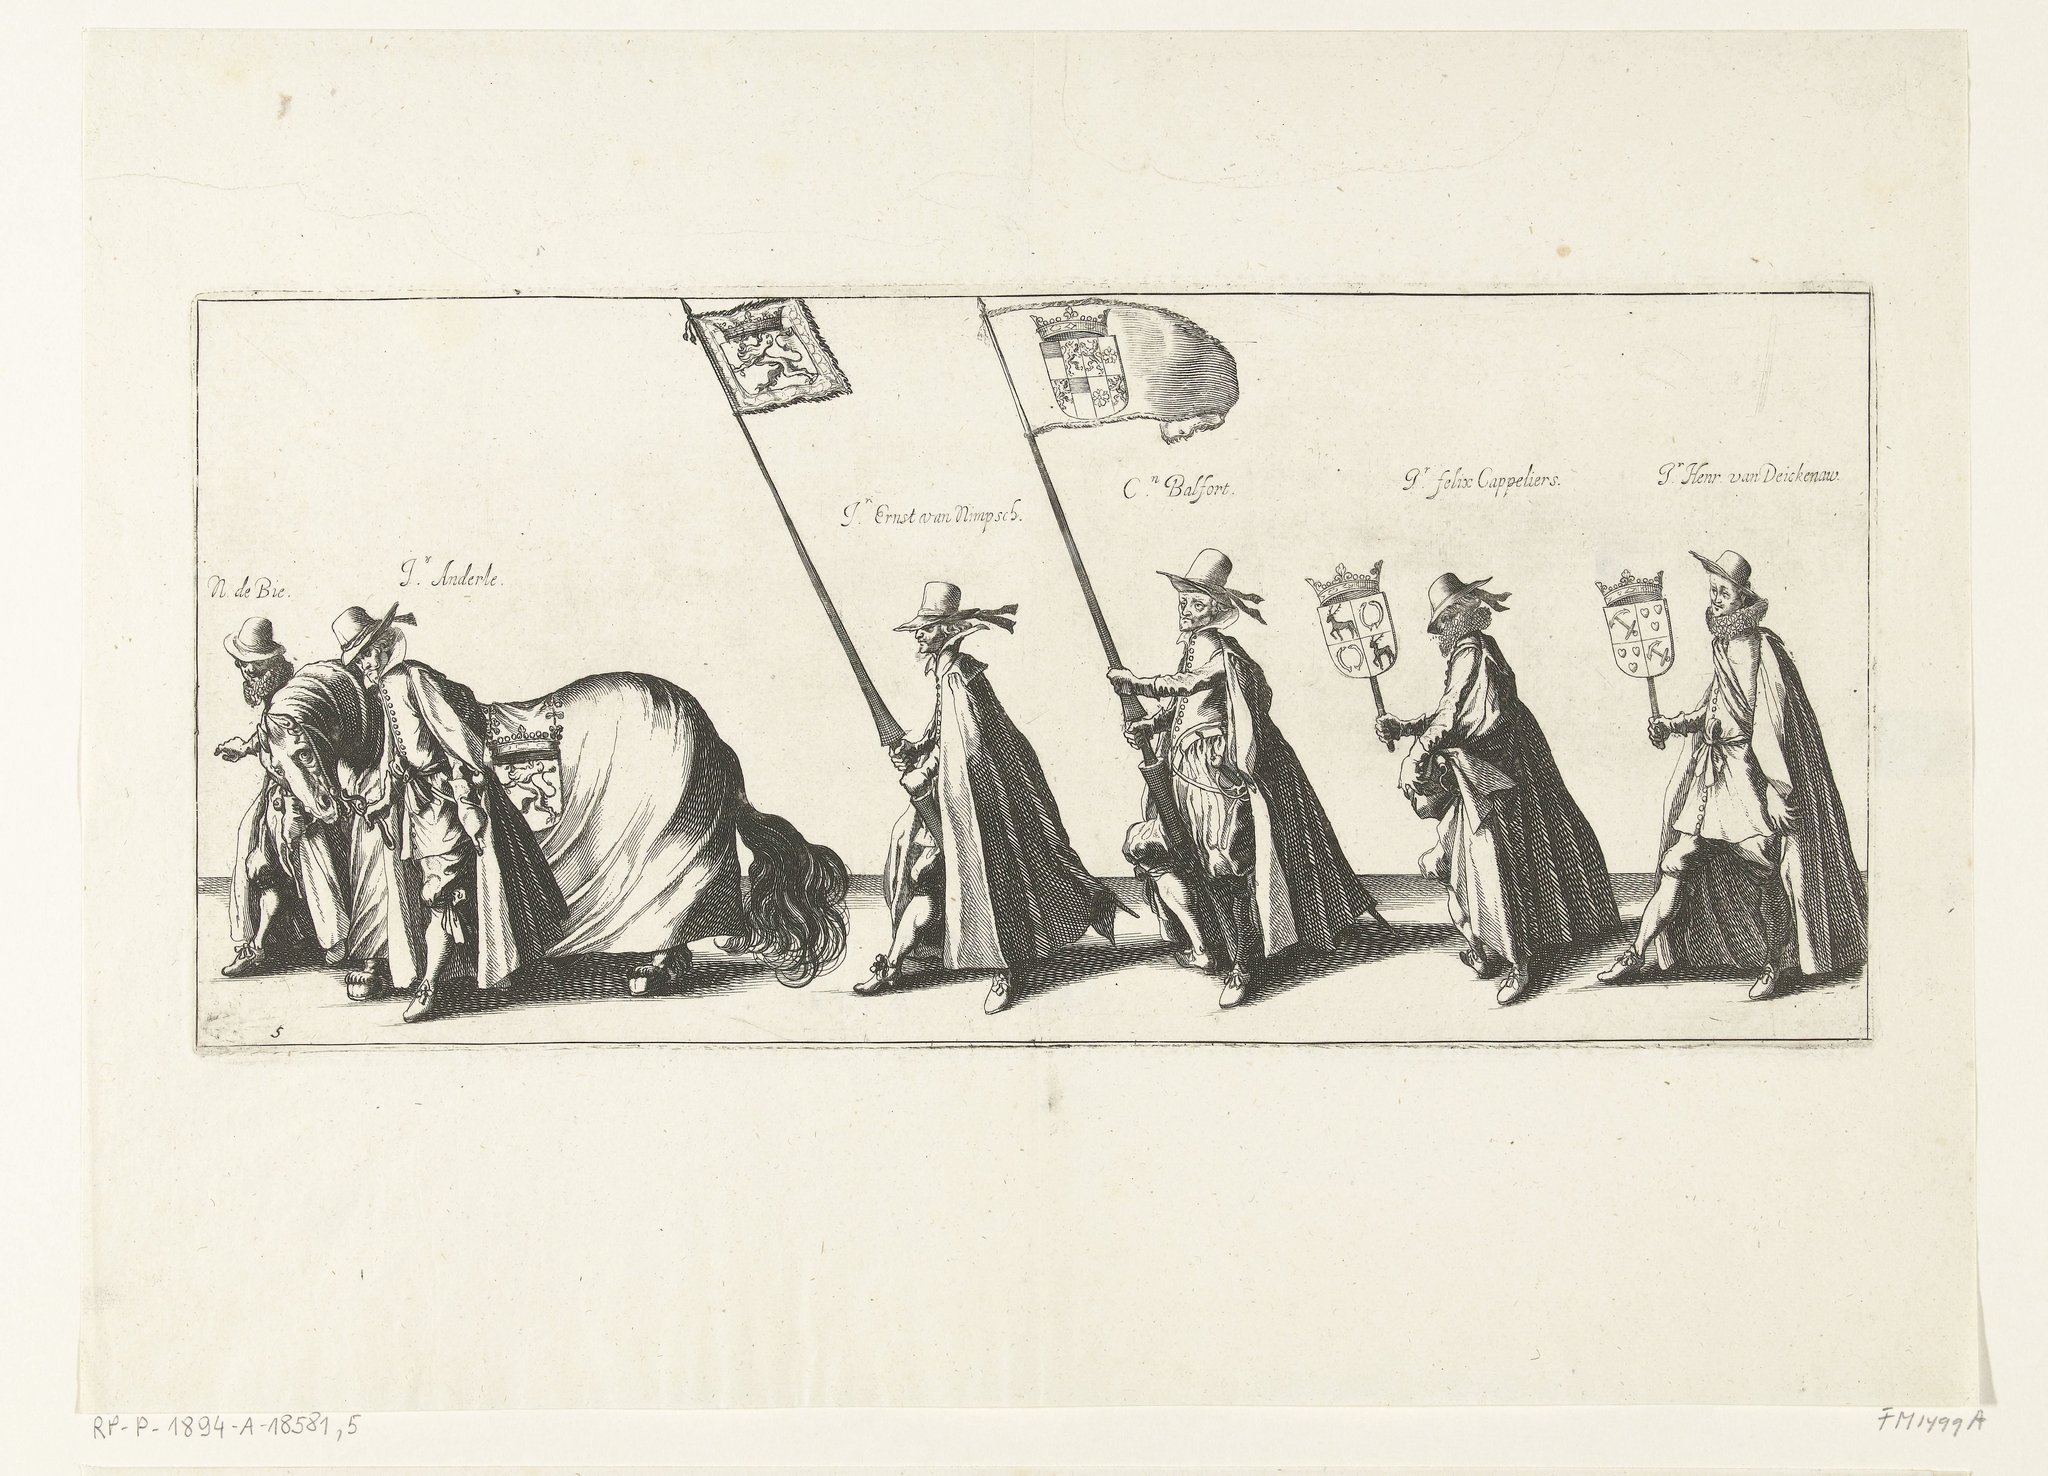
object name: print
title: Begrafenis van Johann Albrecht, graaf van Solms, 1623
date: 1615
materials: paper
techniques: etching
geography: northern netherlands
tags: the hague, cortege, funeral procession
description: De begrafenisstoet (plaat 5). Een paard en twee banieren. Onderdeel van de serie prenten van de begrafenisoptocht van Johann Albrecht, graaf van Solms, op 25 mei 1623 te Den Haag.